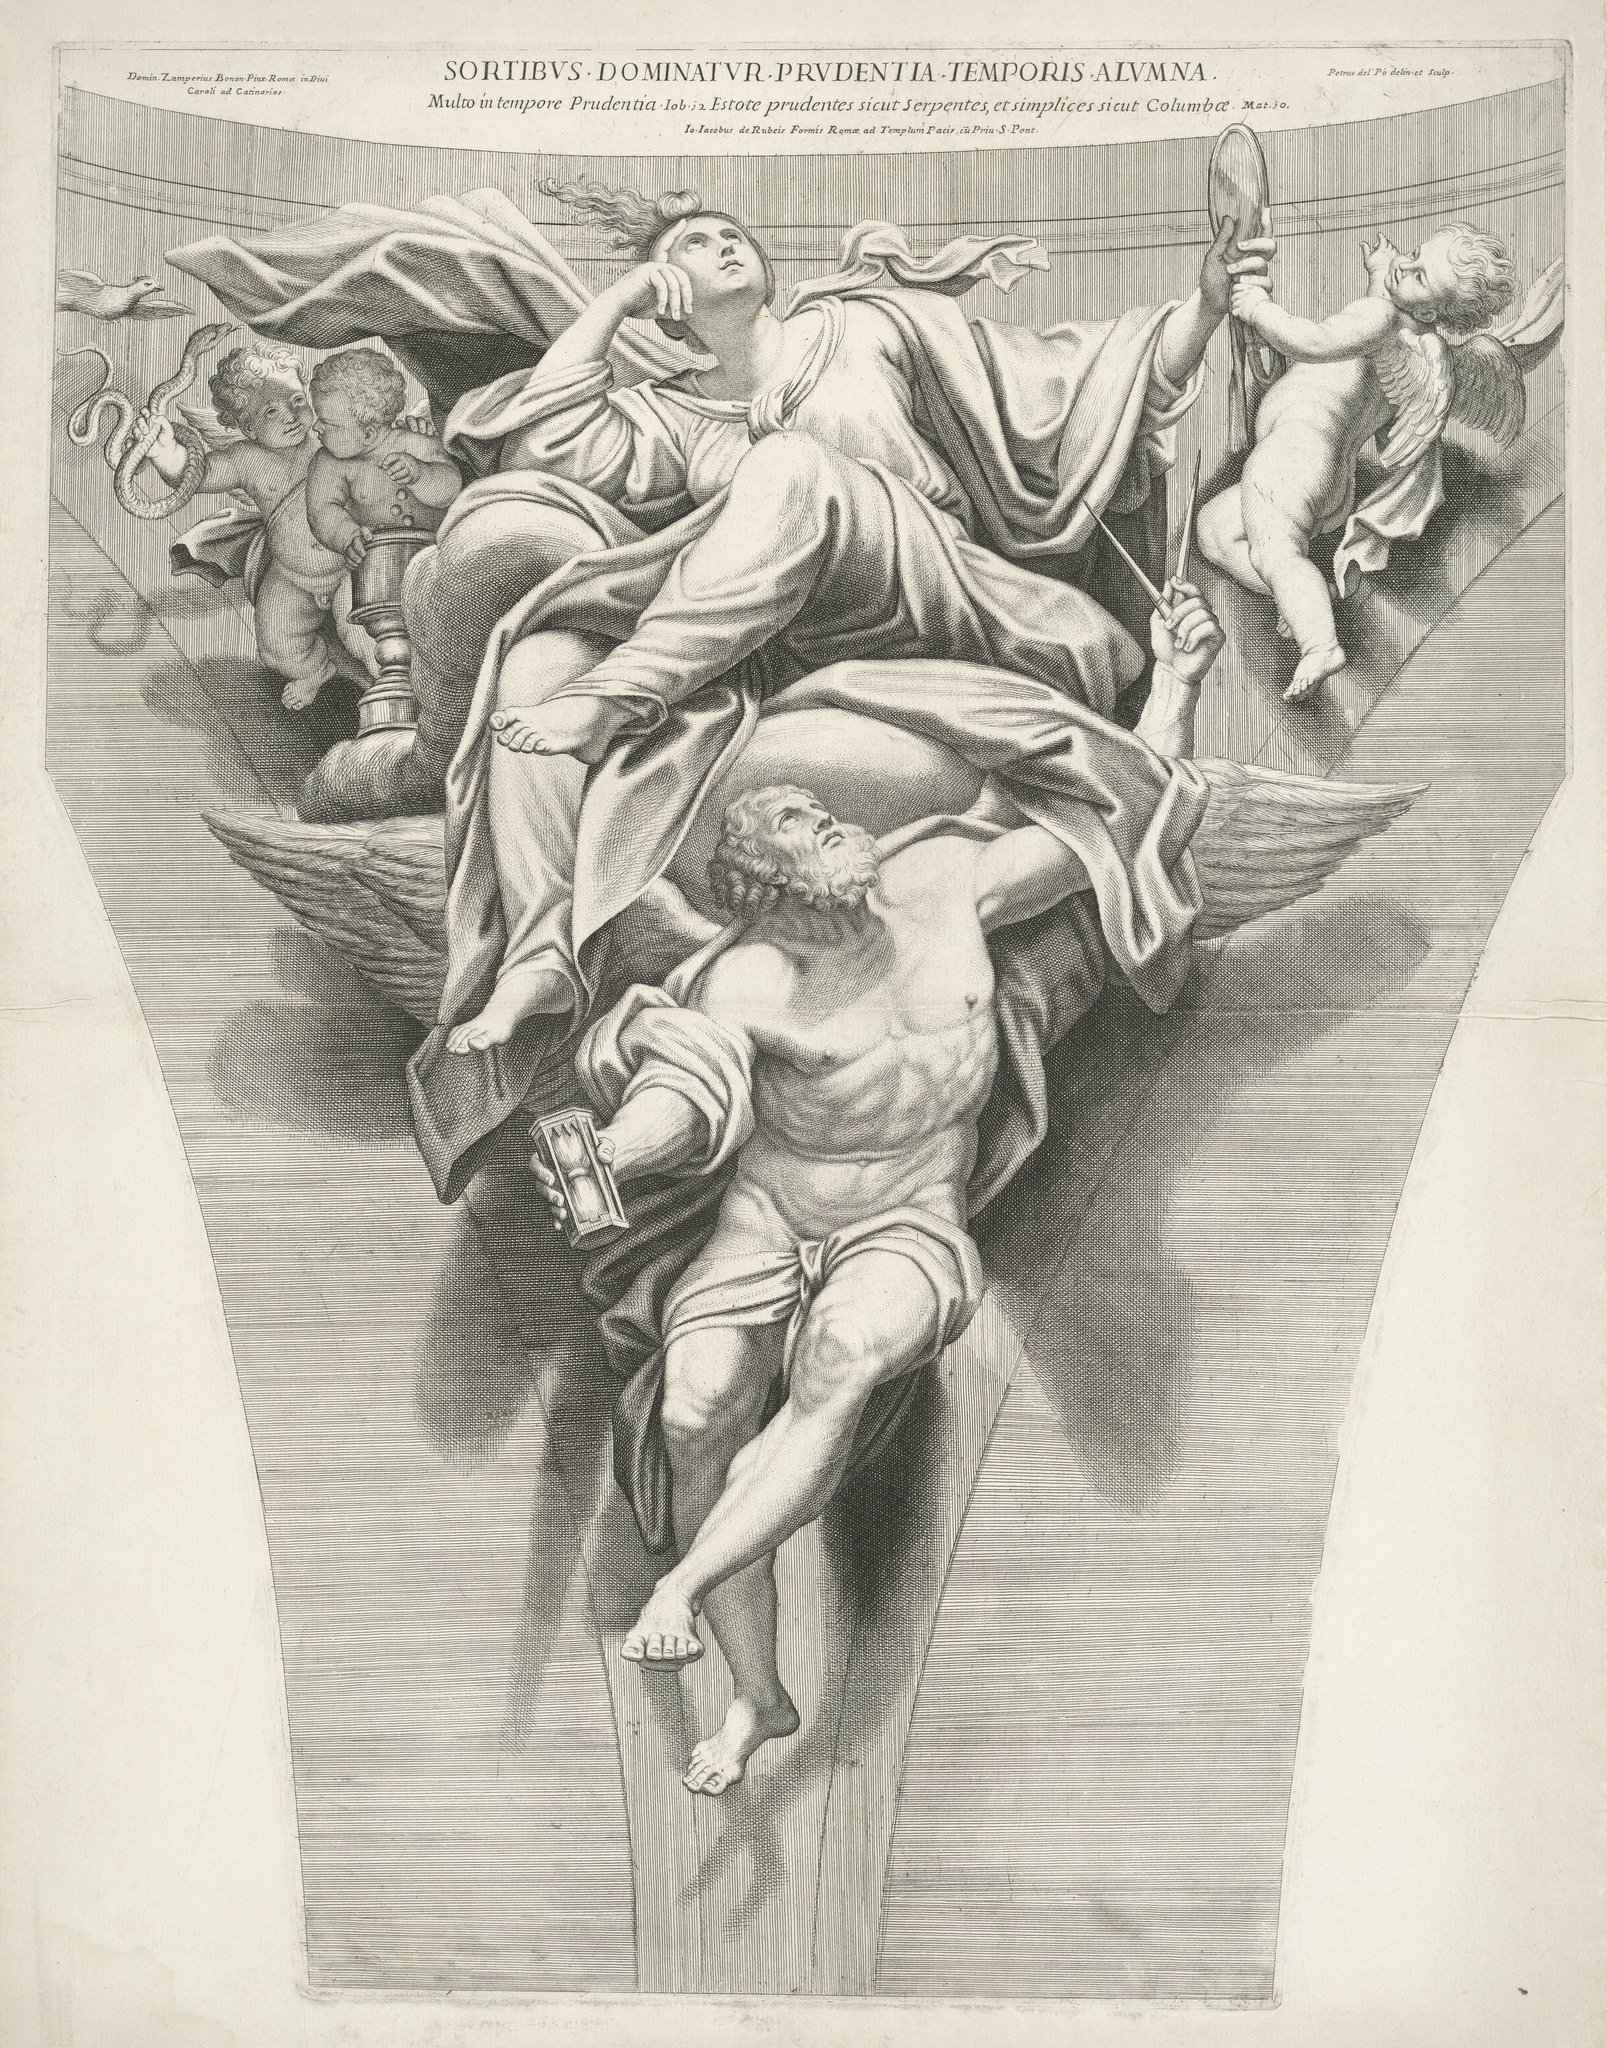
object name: print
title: Kardinale deugden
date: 1620-1692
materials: paper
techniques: engraving, etching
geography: italy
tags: prudence, 'prudentia'; 'prudenza' (ripa) ~ one of the four cardinal virtues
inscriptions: collector's mark: Lugt 240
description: Prent uit een reeks van vier prenten naar de fresco's door Domenichino in de pendentieven onder de koepel van de San Carlo ai Catinari te Rome. Getekende voorstudies door Del Po worden bewaard in Windsor Castle te Windsor.